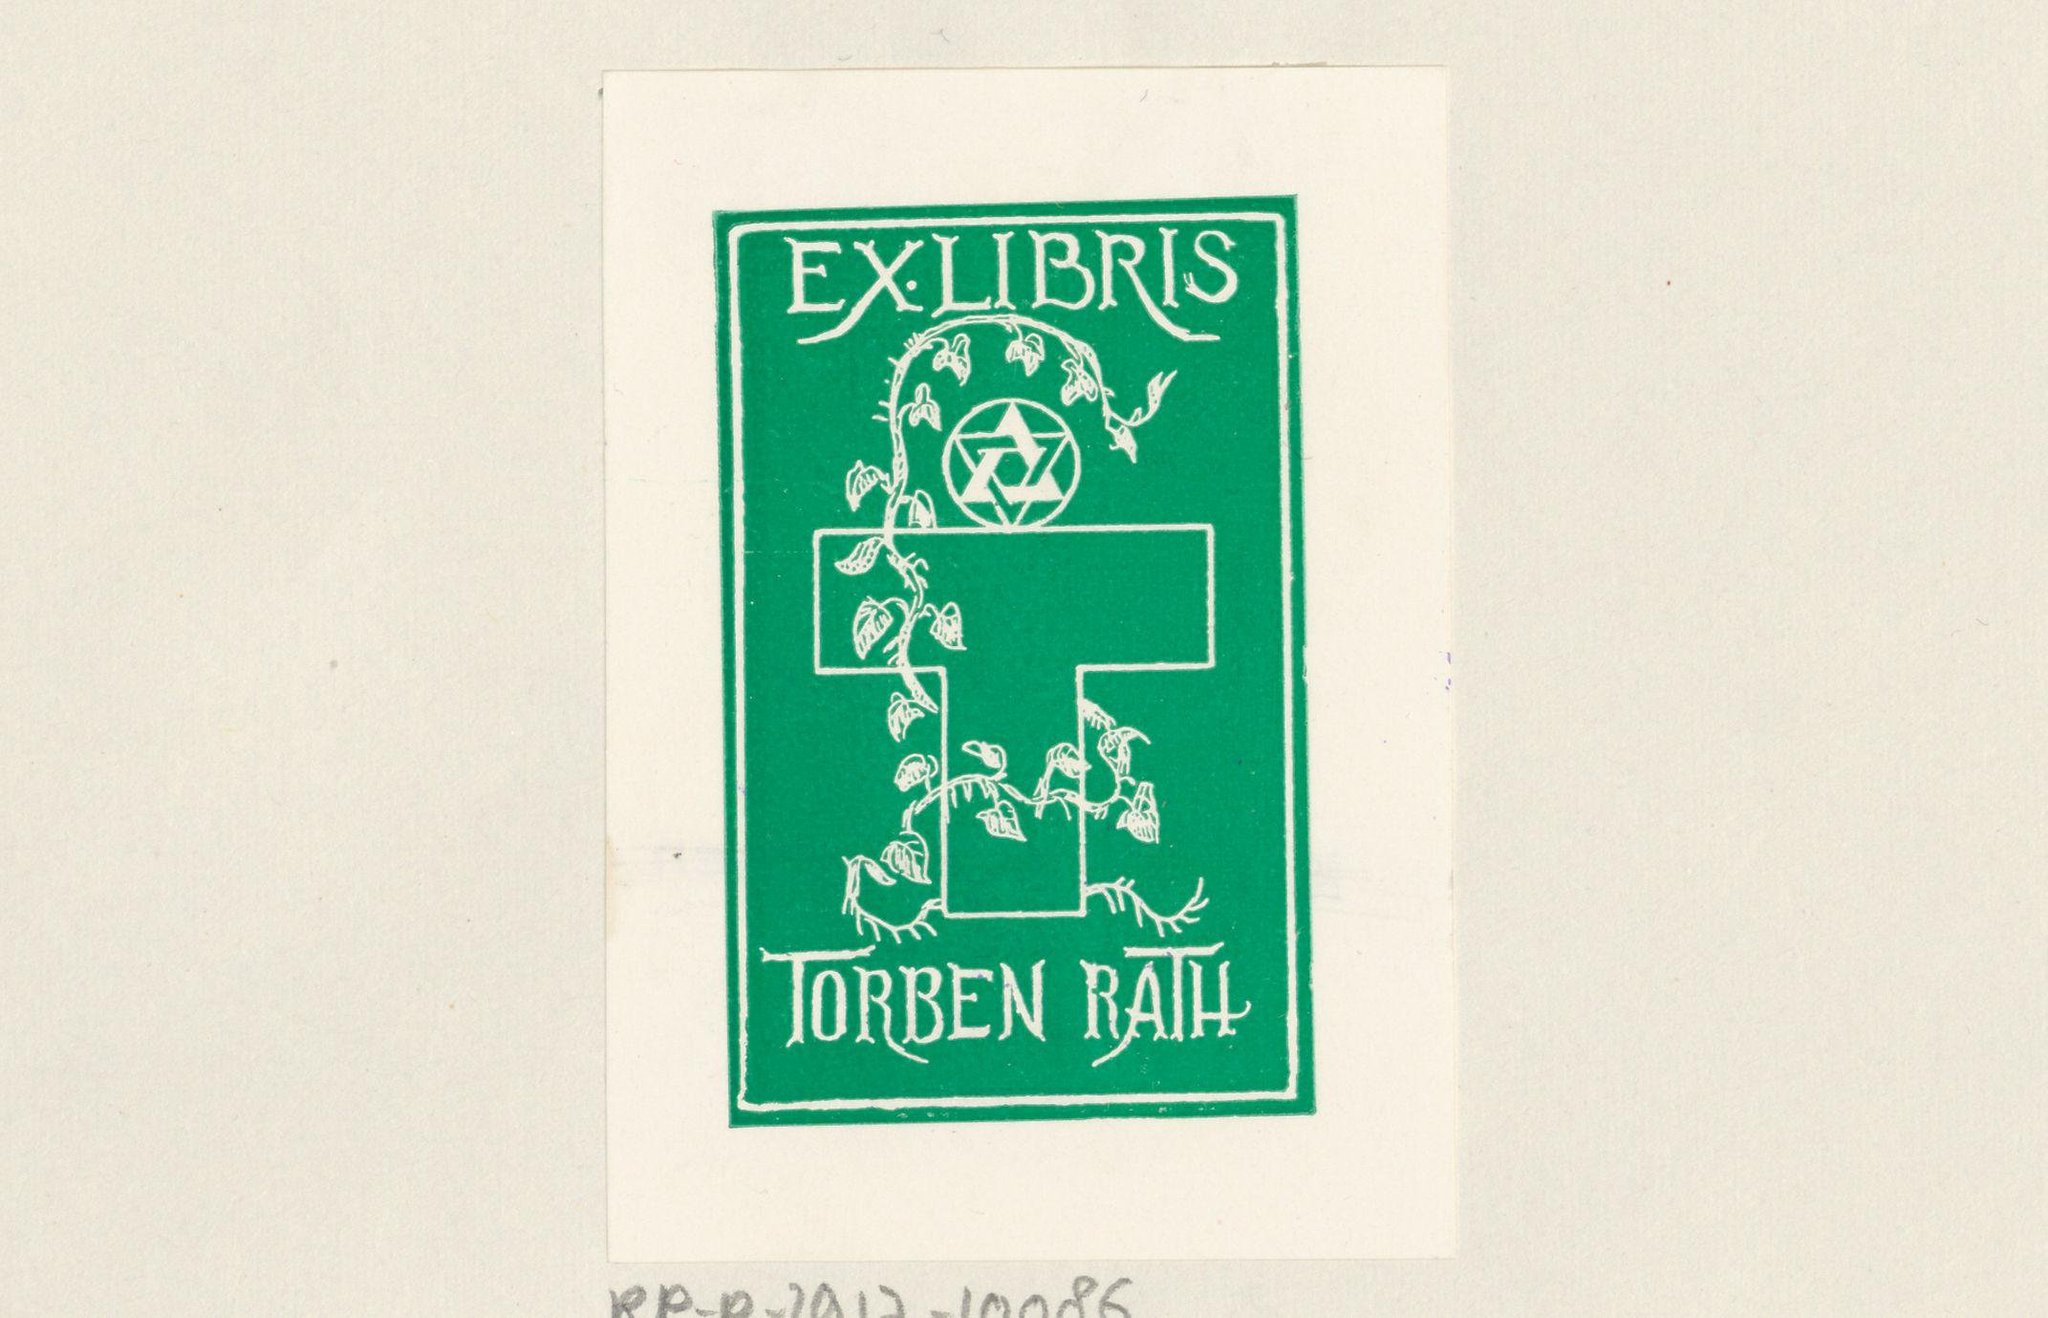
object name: bookplate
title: Ex libris van Torben Rath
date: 1900-1999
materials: paper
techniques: printing block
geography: rudkøbing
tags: stars, plants and herbs: ivy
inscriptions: workshop stamp: ‘K.E. Friis Andreassen/ K.F.U.M./ Rudkøbing/ Danmark’